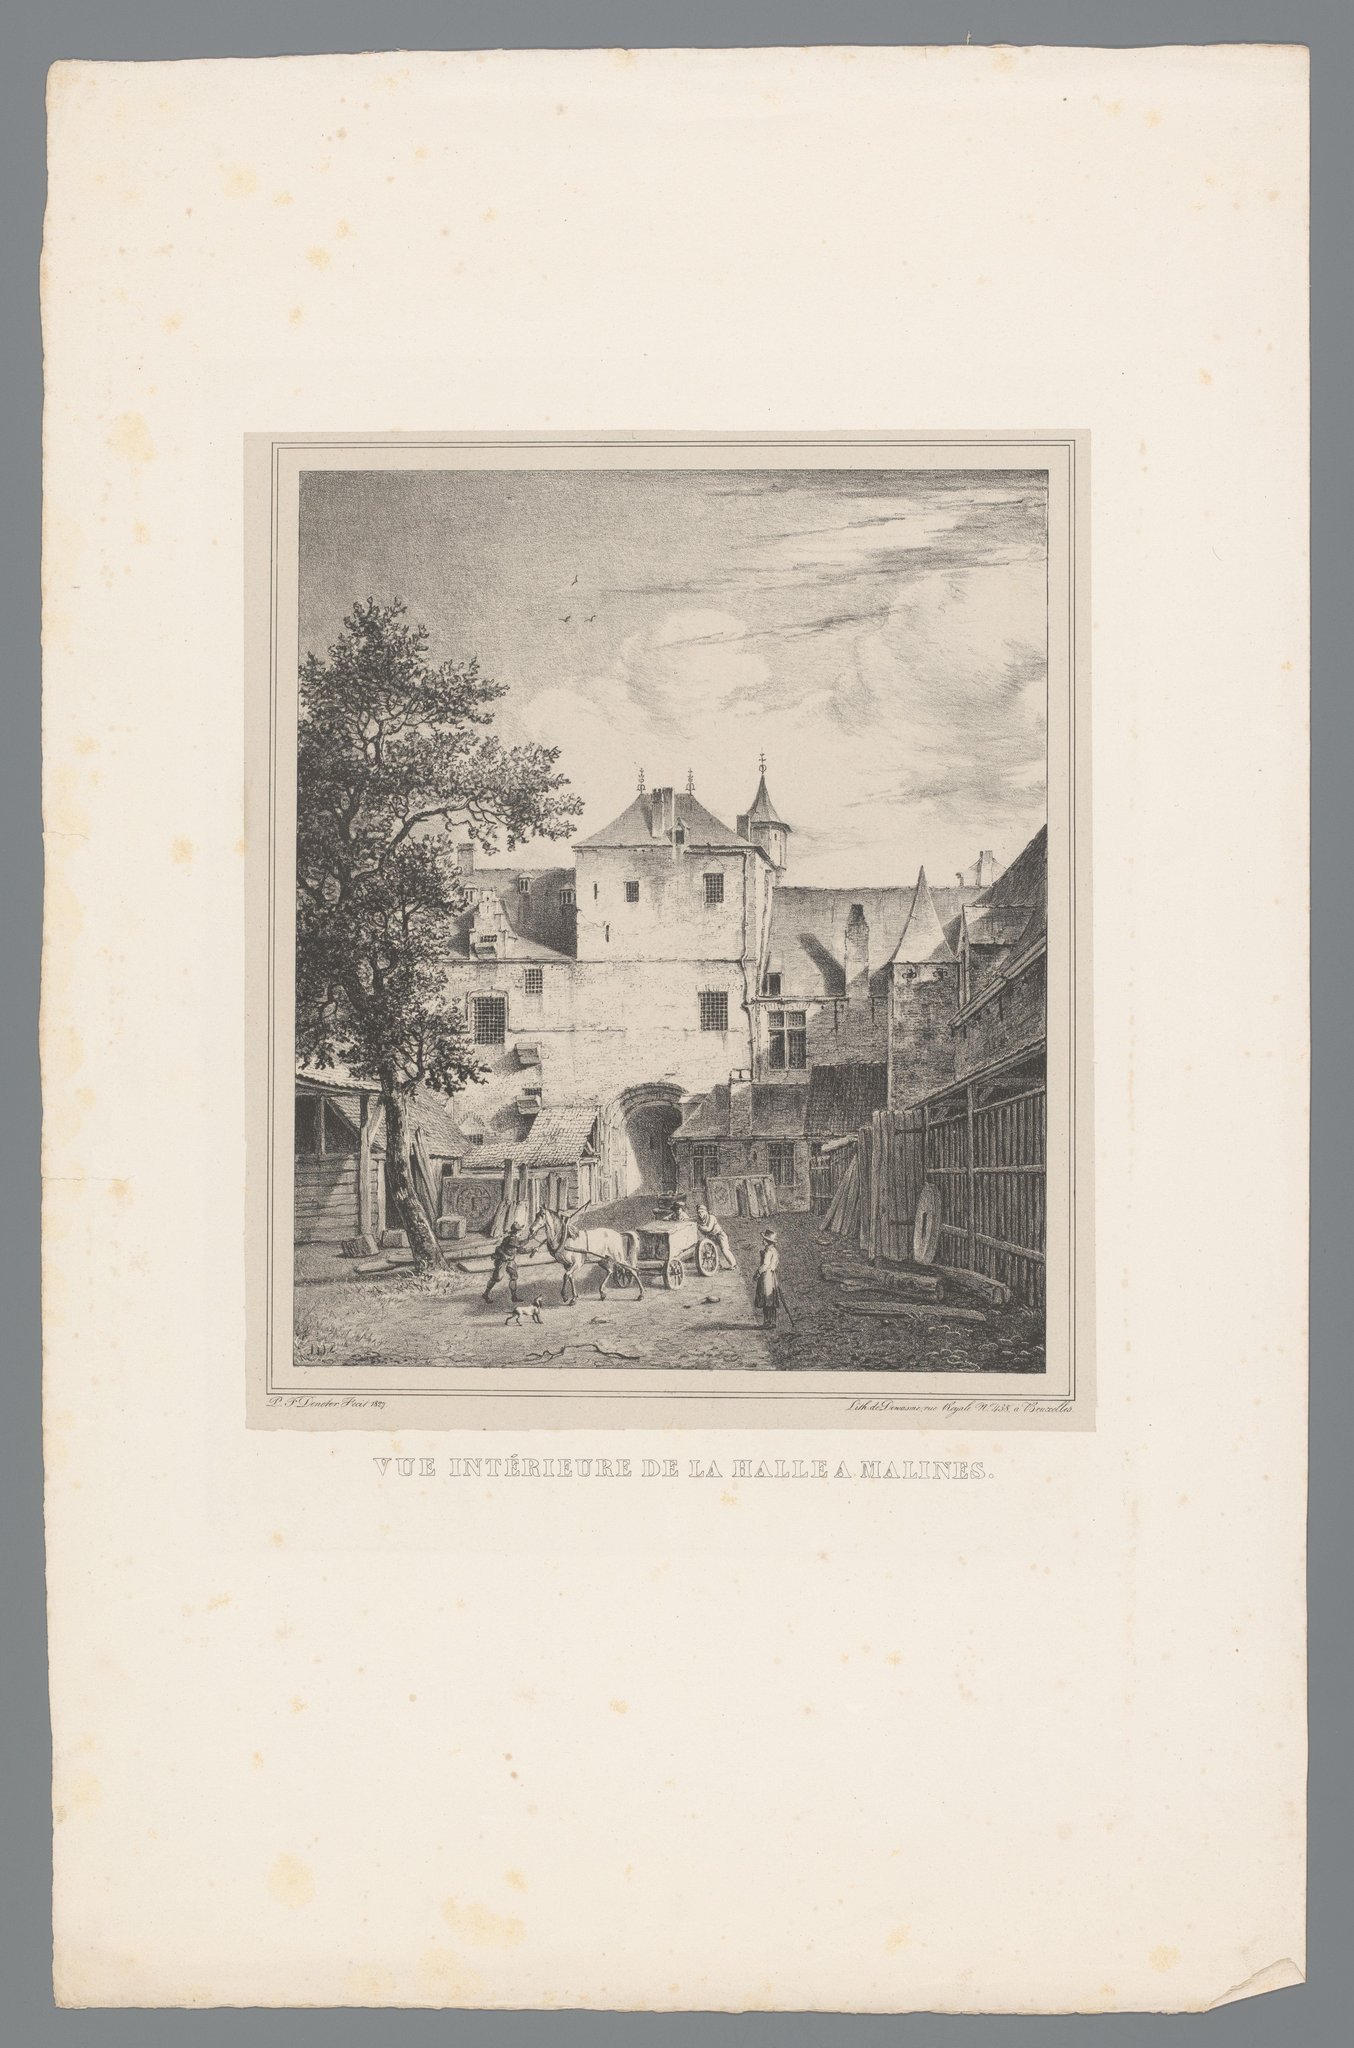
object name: print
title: Vue intérieure de la halle a Malines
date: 1827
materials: paper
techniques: lithograph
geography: brussels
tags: four-wheeled vehicle drawn by one animal, city-view in general; 'veduta', courtyard, mechelen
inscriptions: date